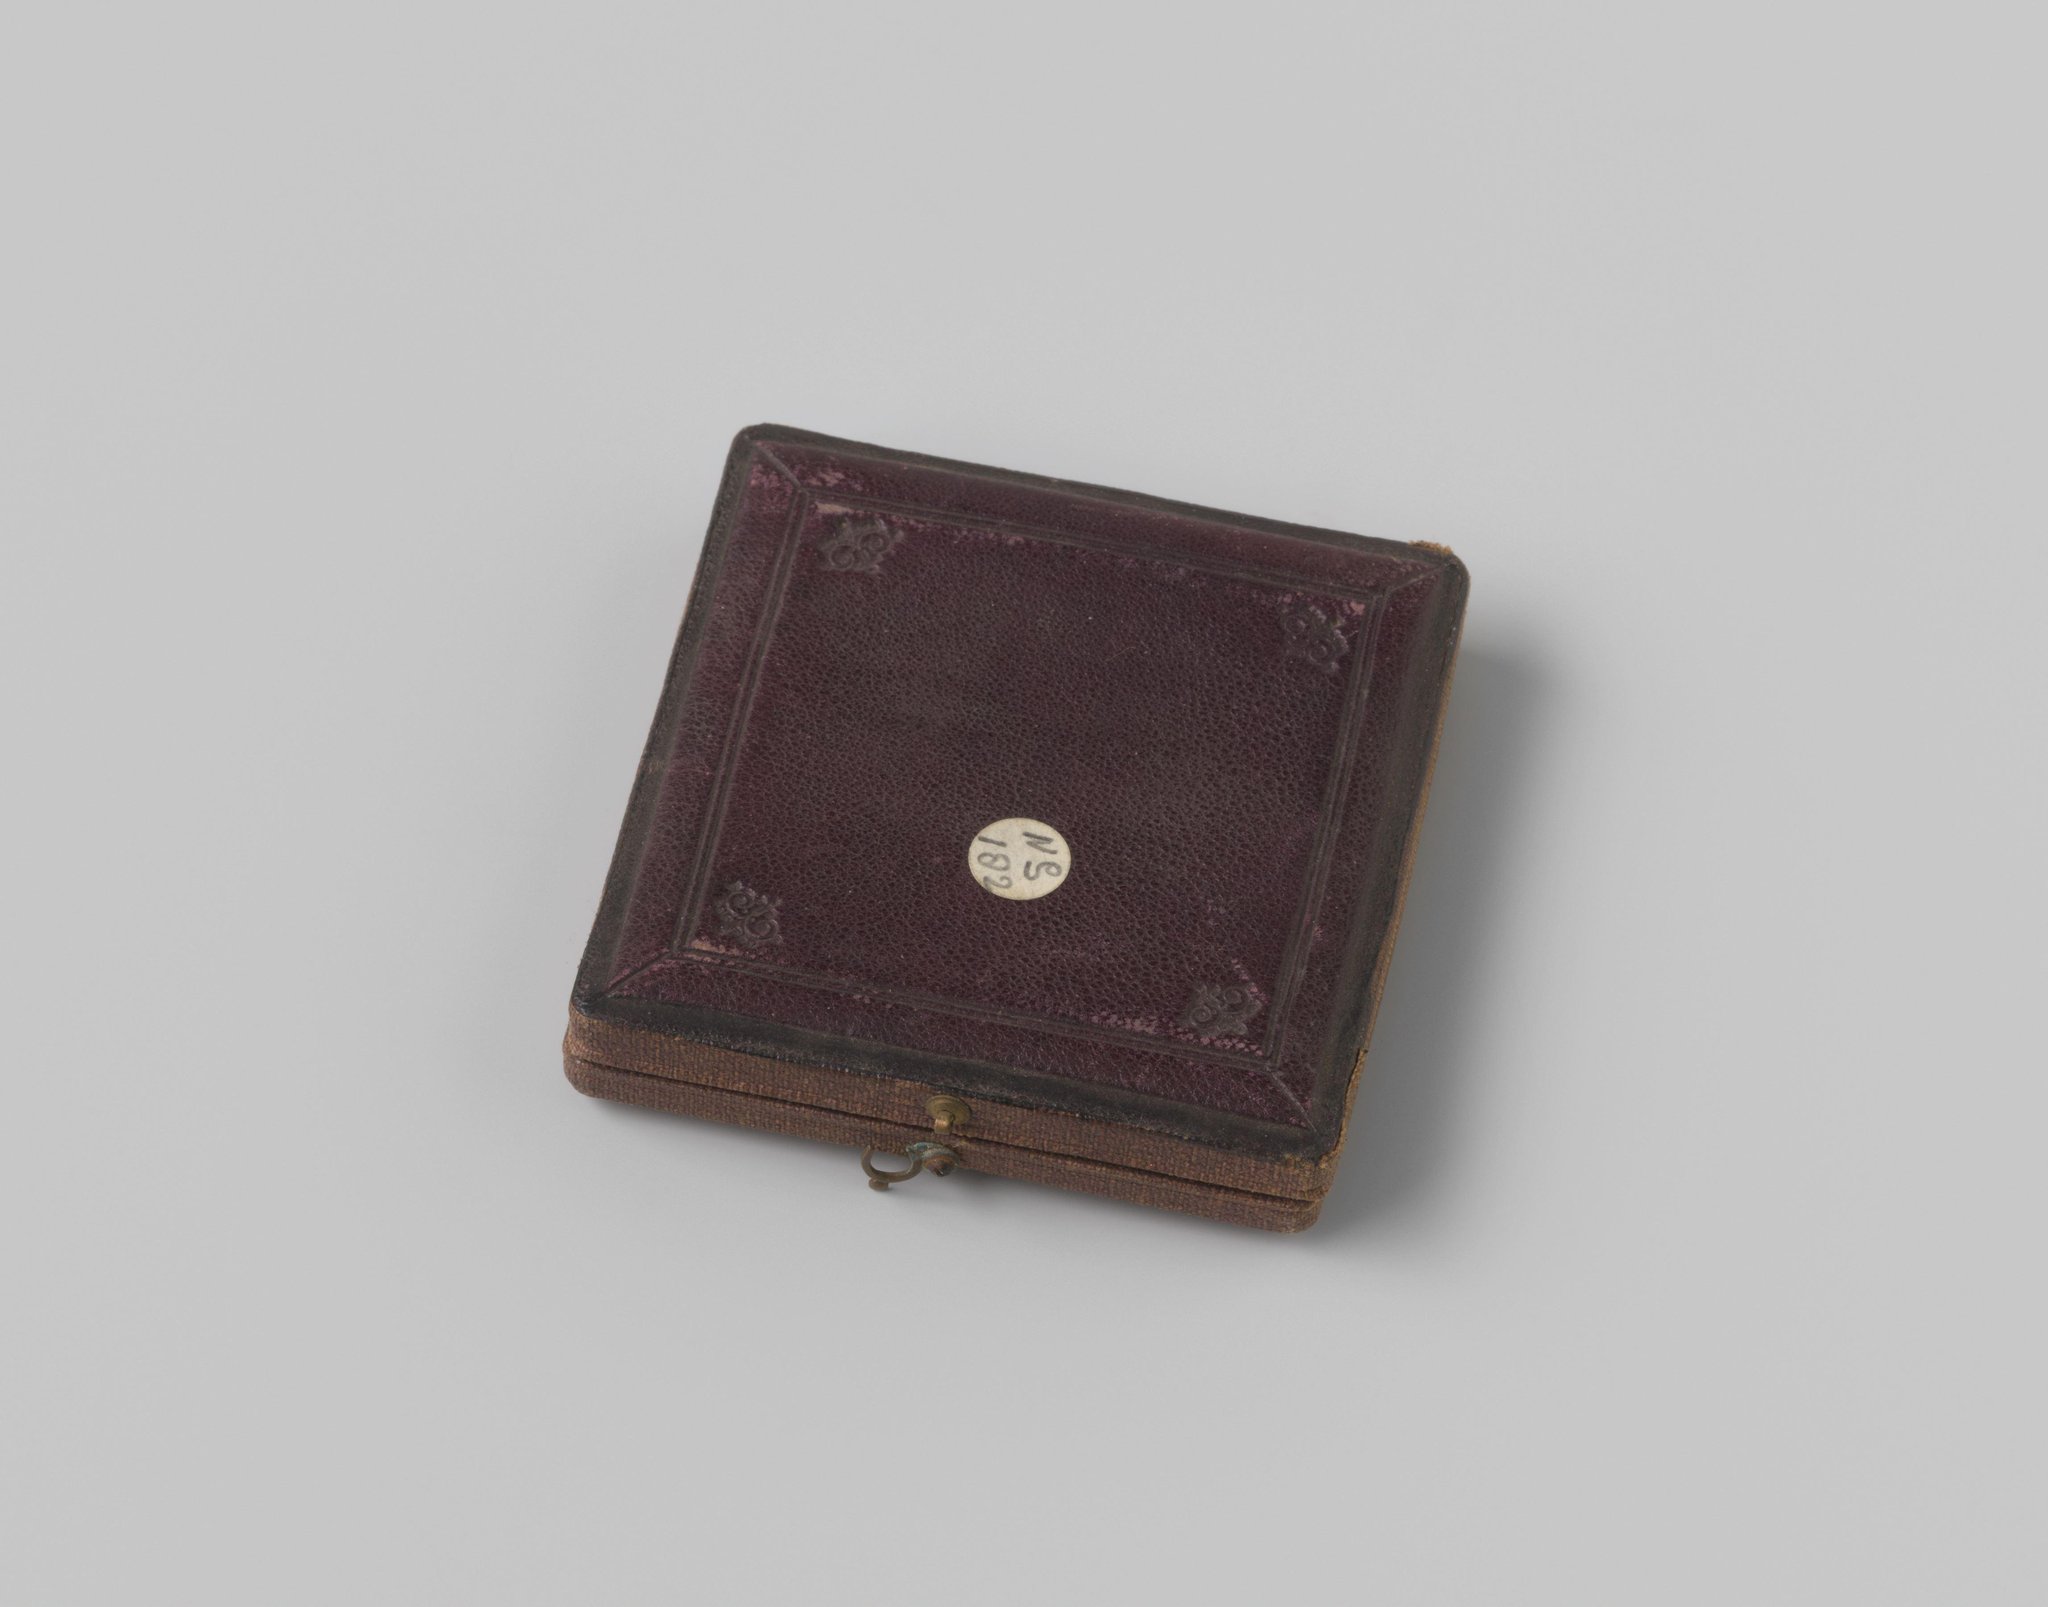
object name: box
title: Doos horend bij een bronzen penning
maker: david van der kellen (1804-1879)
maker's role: die cutter, draughtsman, print maker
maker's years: 1804-1879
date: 1861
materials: cardboard, velvet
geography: utrecht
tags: haarlem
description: Leren vierkante doosje met koperen sluiting. Binnenzijde bekleedt met rood fluweel.